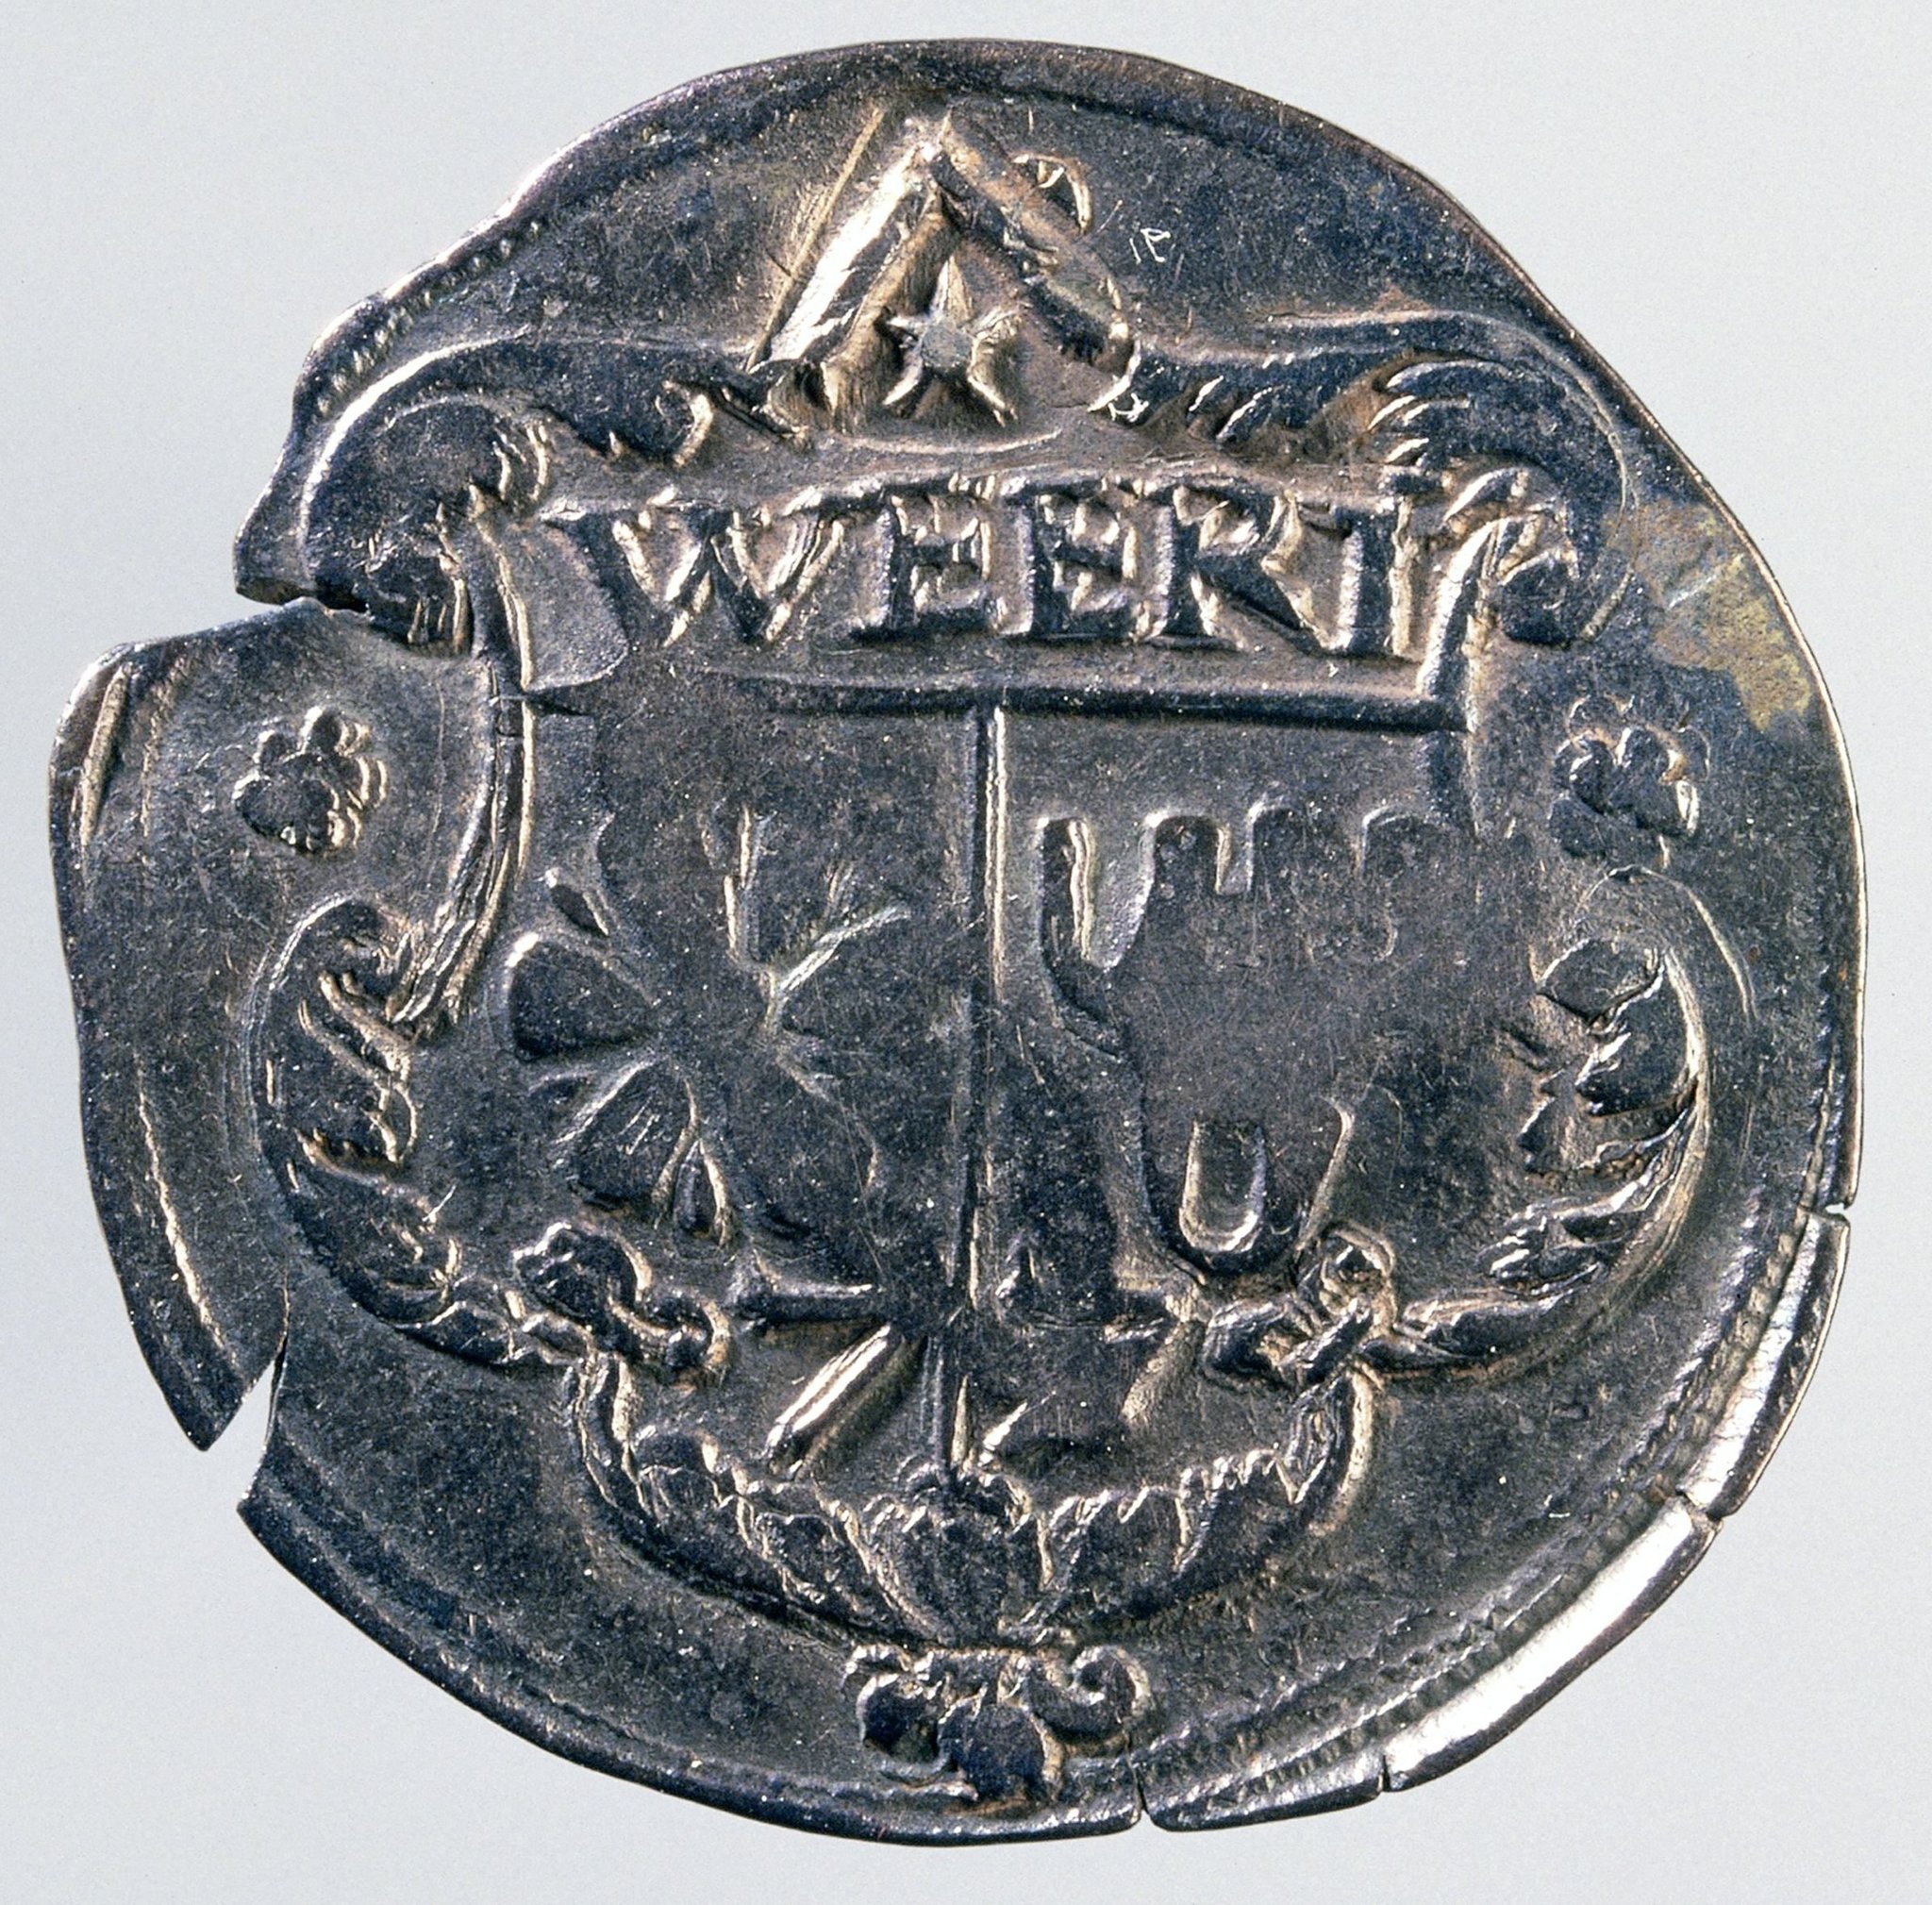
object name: medal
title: Oord van Weert, mogelijk als gildepenning gebruikt door het linnenweversgilde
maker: Anonymous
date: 1566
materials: copper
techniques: striking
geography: weert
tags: weert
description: Koperen penning. Voorzijde: wapenschild in cartouche. Keerzijde: wapenschild in cartouche; daarover in drie stempels: een weversspoel, het cijfer 3 een keper. Vermoedelijk een gildepenning.